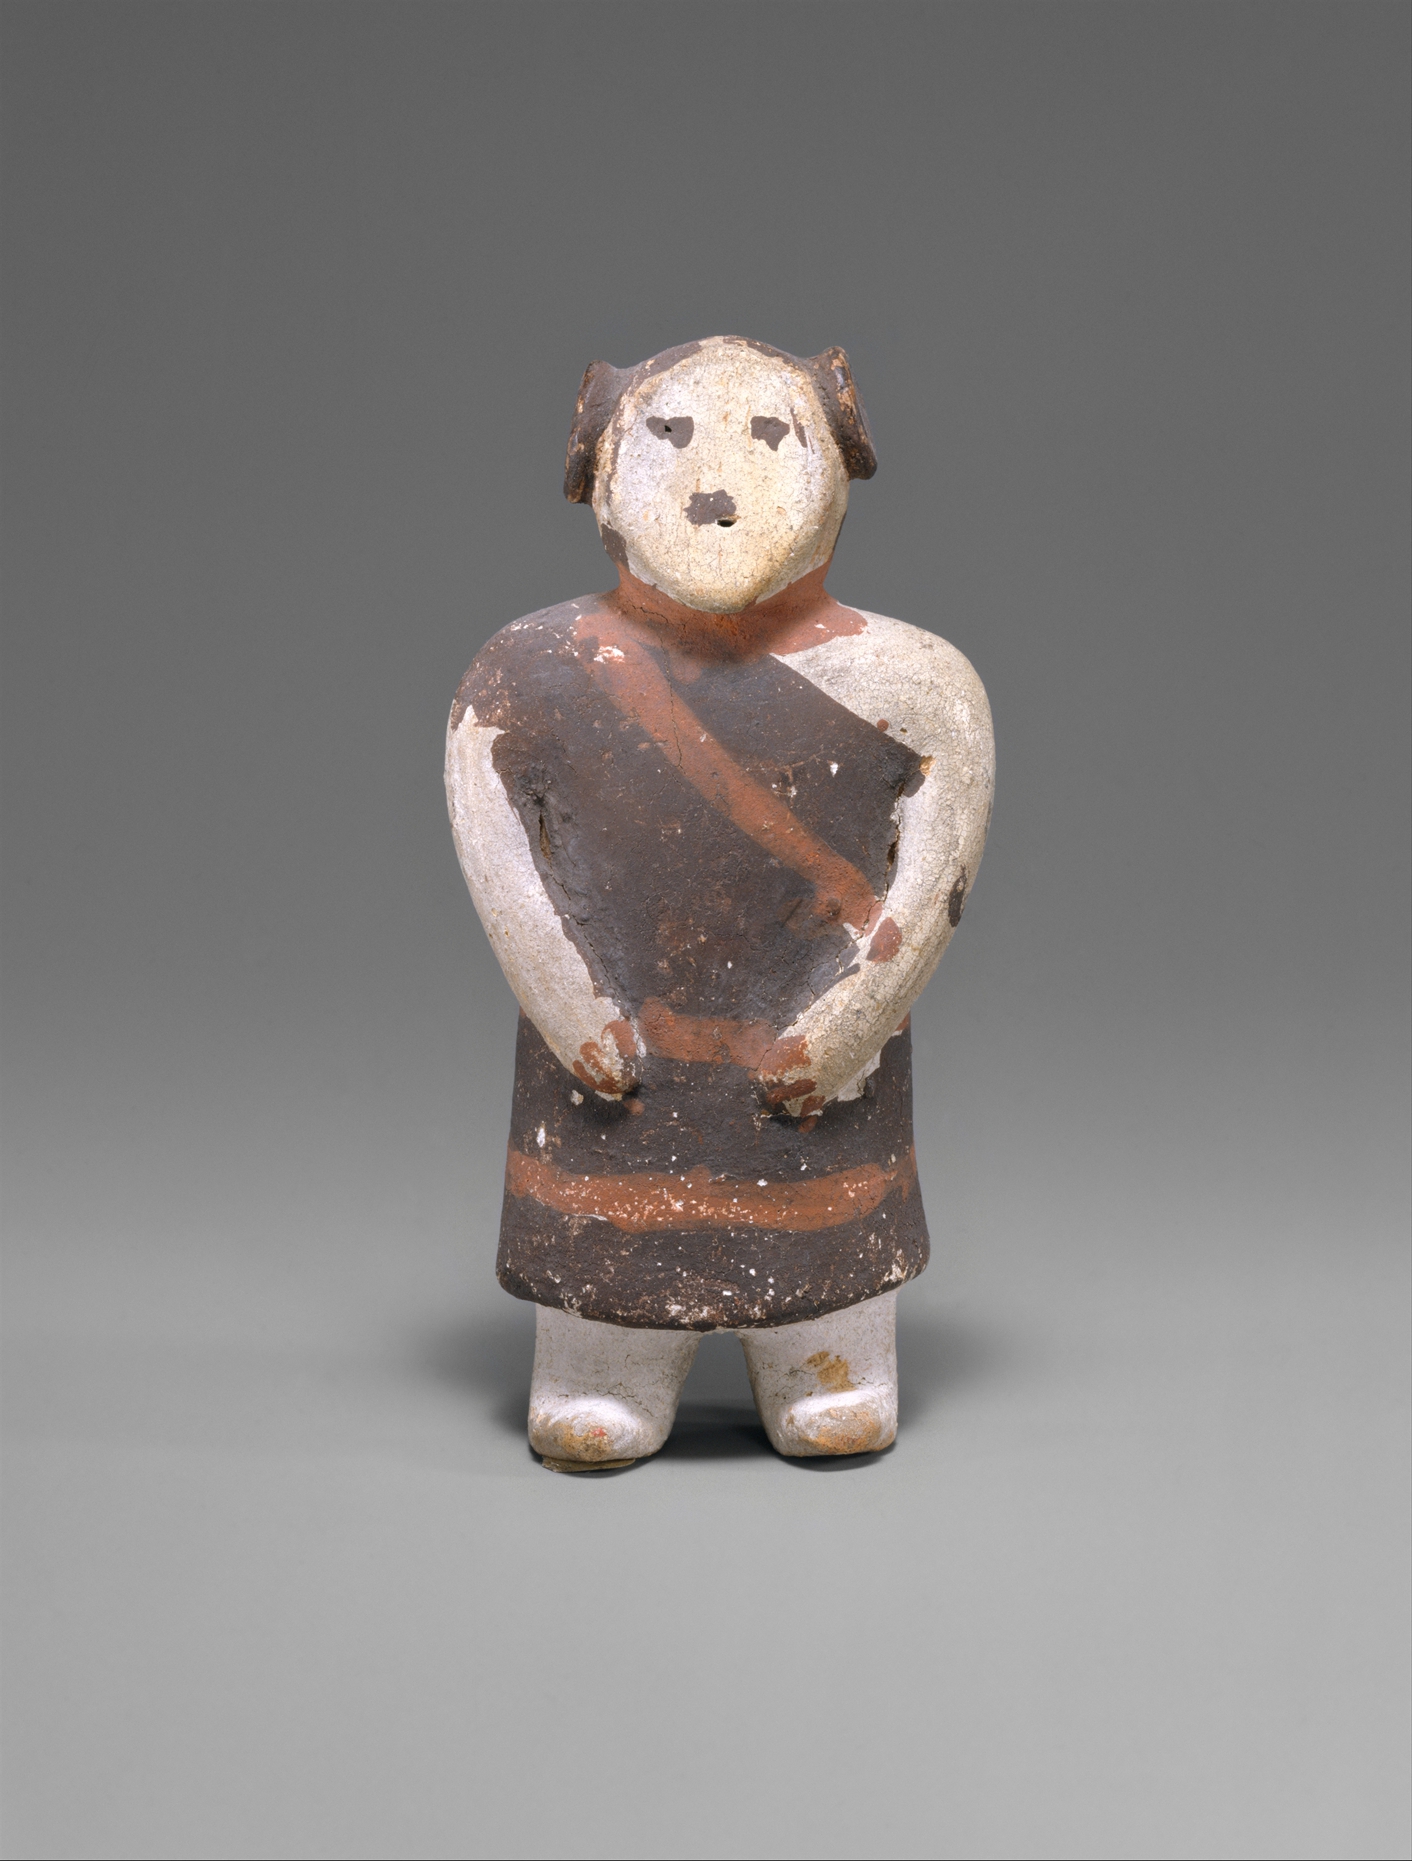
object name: doll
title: Figurine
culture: zuni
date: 1879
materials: ceramic, pigment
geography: united states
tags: human figures